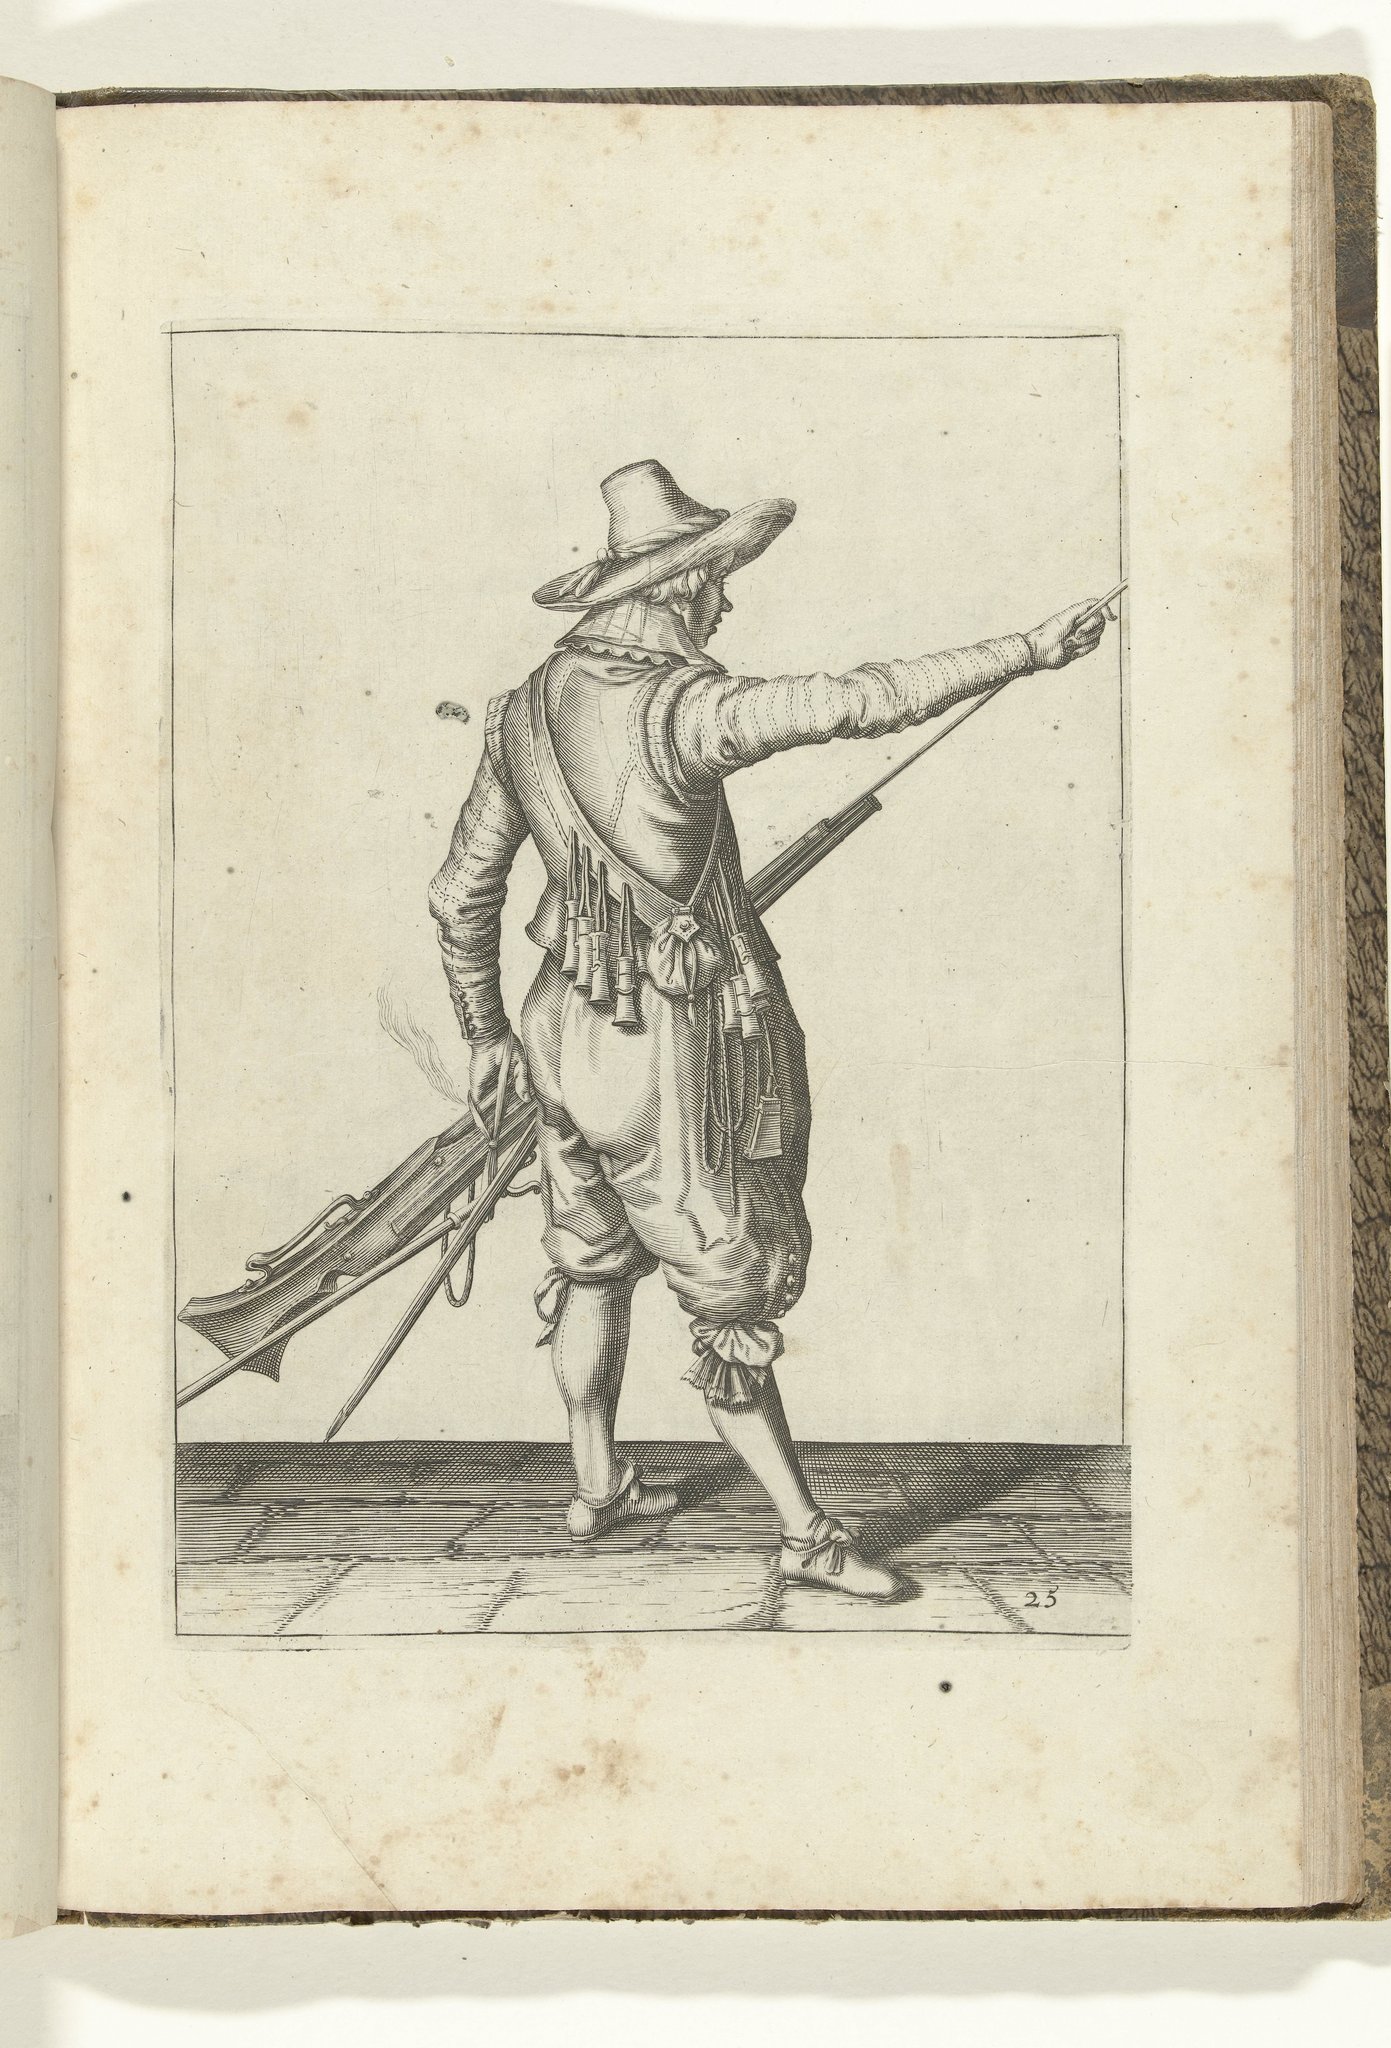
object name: print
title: Soldaat die zijn laadstok uit de houder onder de loop van zijn musket haalt (nr. 25), ca. 1600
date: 1597-1608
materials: paper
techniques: engraving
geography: northern netherlands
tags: the hague, maurice (prince of orange), handling of weapons ~ military training, weapons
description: Een soldaat, ten voeten uit, naar rechts, op de rug gezien, die met zijn linkerhand bij zijn linkerdijbeen een musket (een bepaald type vuurwapen) vasthoudt en met zijn rechterhand de laadstok uit de houder onder de loop haalt (nr. 25), ca. 1600. In zijn linkerhand behalve het musket ook een brandende lont; aan zijn linkerpols een furket (musketvork). Plaat 25 in de instructies voor het hanteren van het musket: Brief enseignement, sur les pourtraitz figurez, touchant le droit maniement du Mousquet. Onderdeel van de illustraties in een Franse editie van J. de Gheyns Wapenhandelinghe: J. de Gheyn, Maniement d'armes, d'arquebuses, mousquetz et piques : en conformité de l'ordre de Mour le Prince Maurice, Prince d'Orange, Amsterdam 1608. Krijgswezen rond 1600.